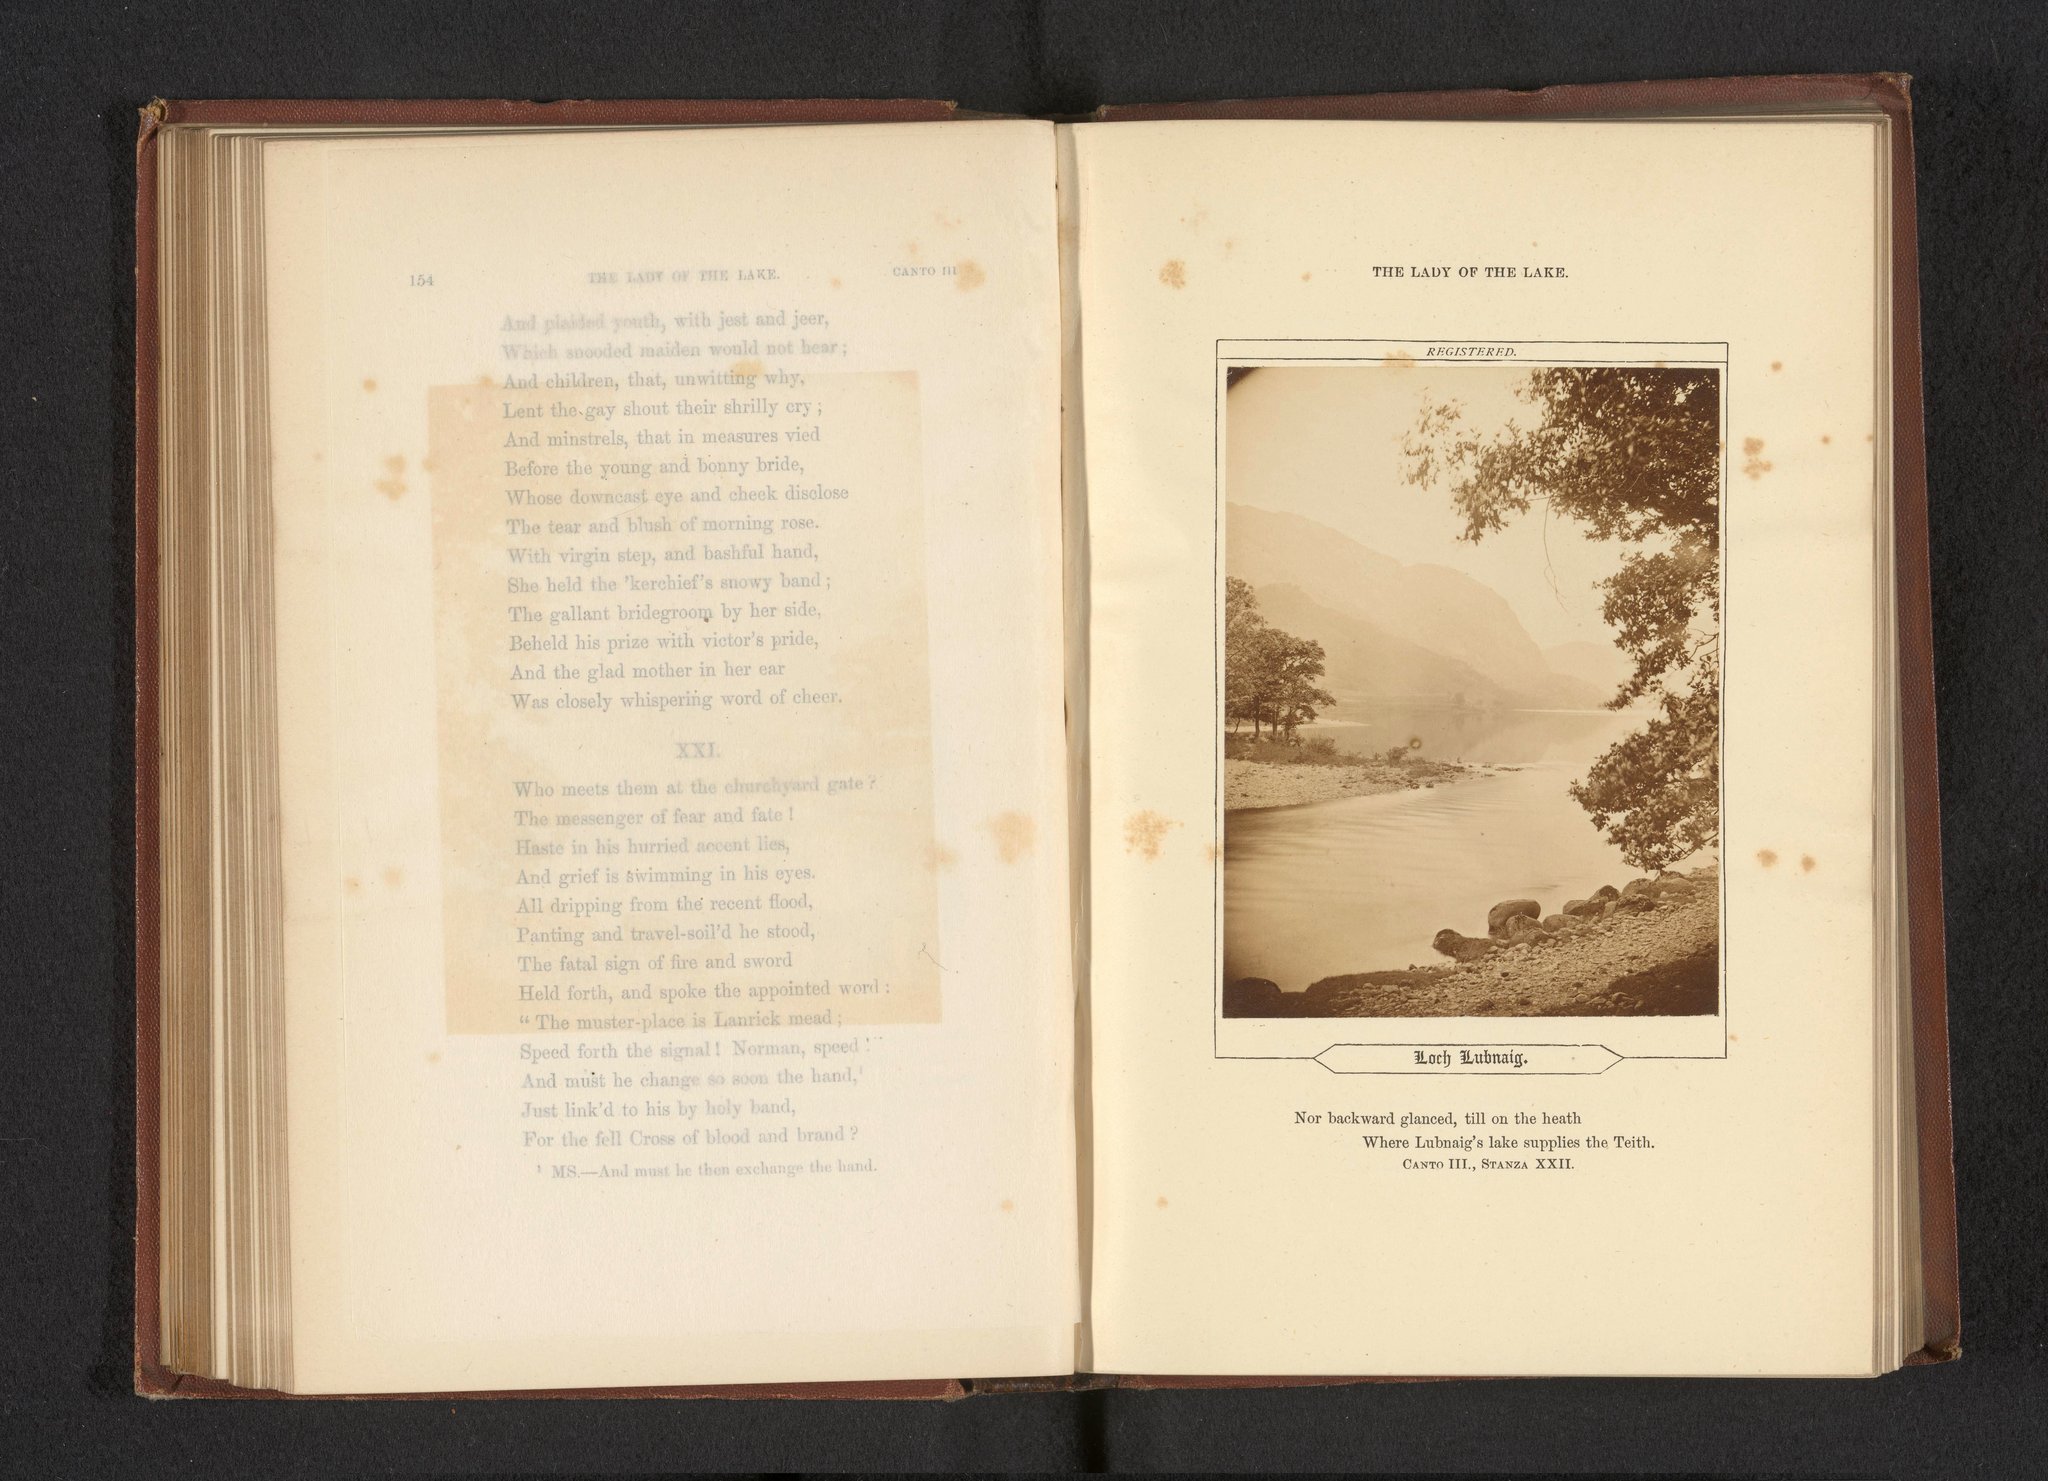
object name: page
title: Gezicht op Loch Lubnaig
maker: george washington wilson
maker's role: publisher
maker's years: 1823-1893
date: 1861-1871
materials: photographic support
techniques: albumen print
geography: loch lubnaig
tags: lake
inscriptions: inscription: ‘Nor backward glanced, till on the heath Where Lubnaig's lake supplies the Teith. Canto III., Stanza XXII.’